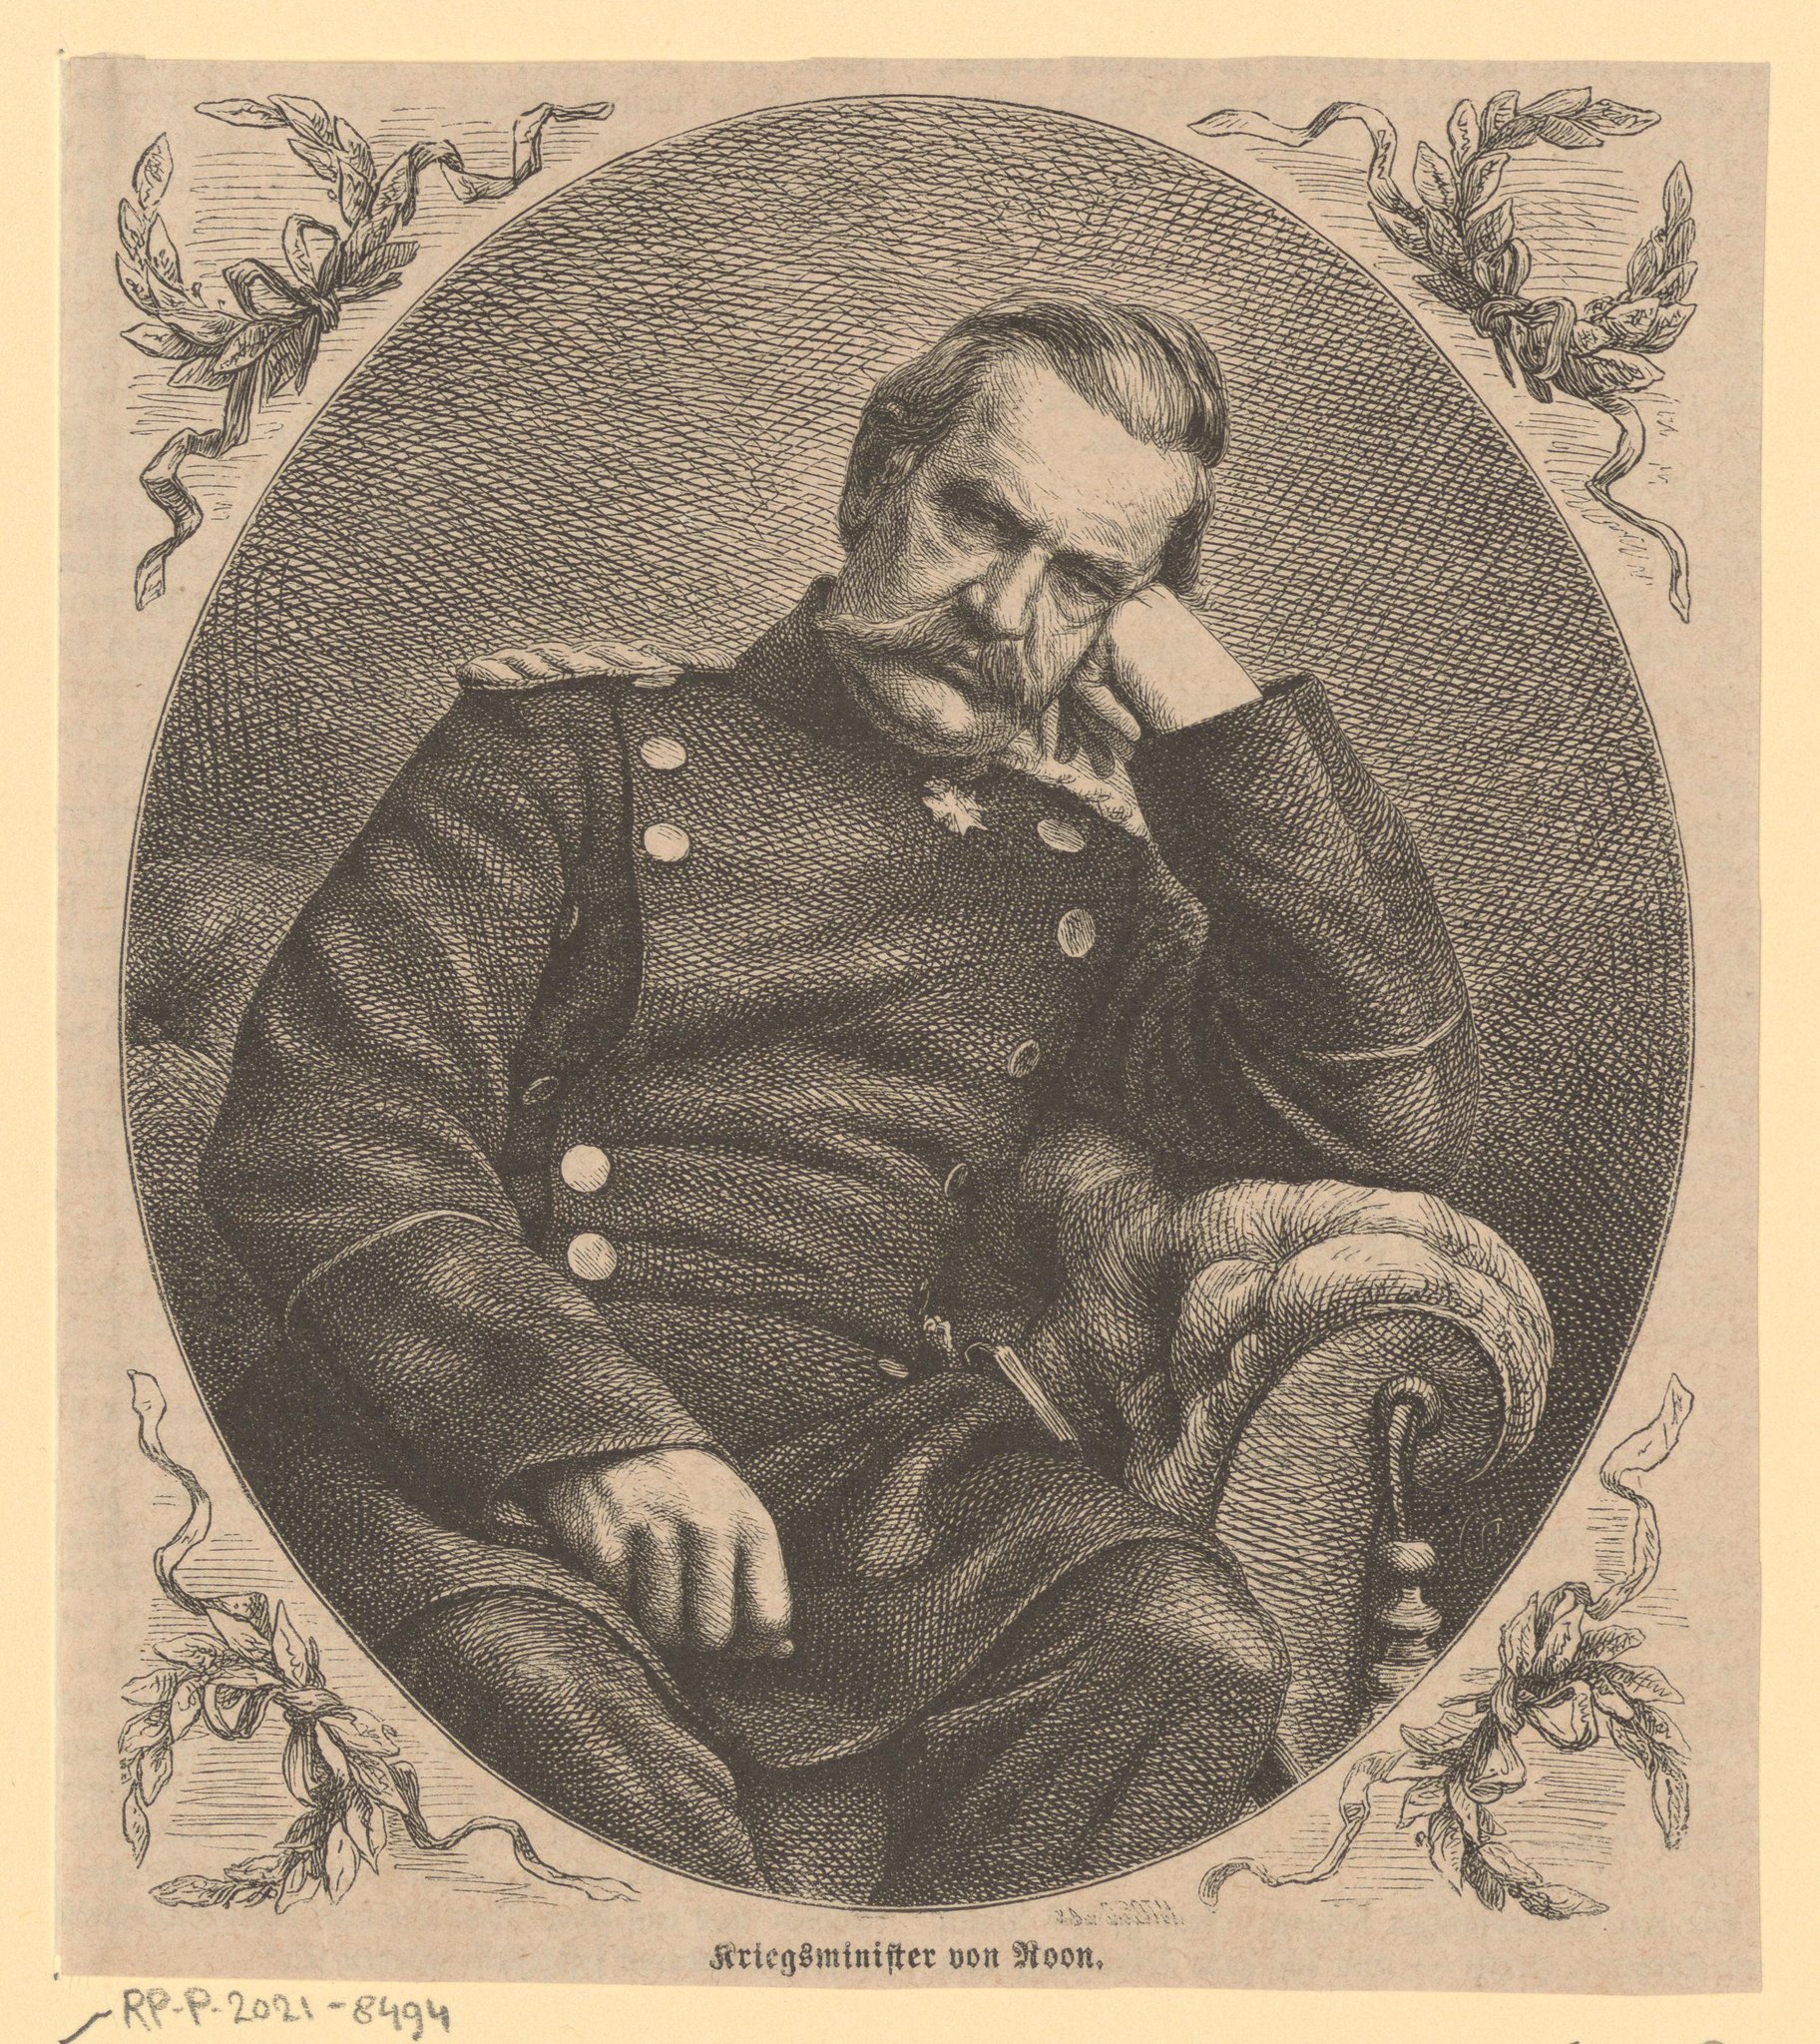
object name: print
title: Portret van graaf Albrecht Theodor Emil von Roon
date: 1870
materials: paper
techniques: letterpress printing, line block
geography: leipzig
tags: poland, berlin, politician, historical persons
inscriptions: signature: ‘CC’, stamp: ‘JVB’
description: Prent uit: Daheim: ein Deutsches Familienblatt mit Illustrationen 6 (1870), nr. 45, 1870.